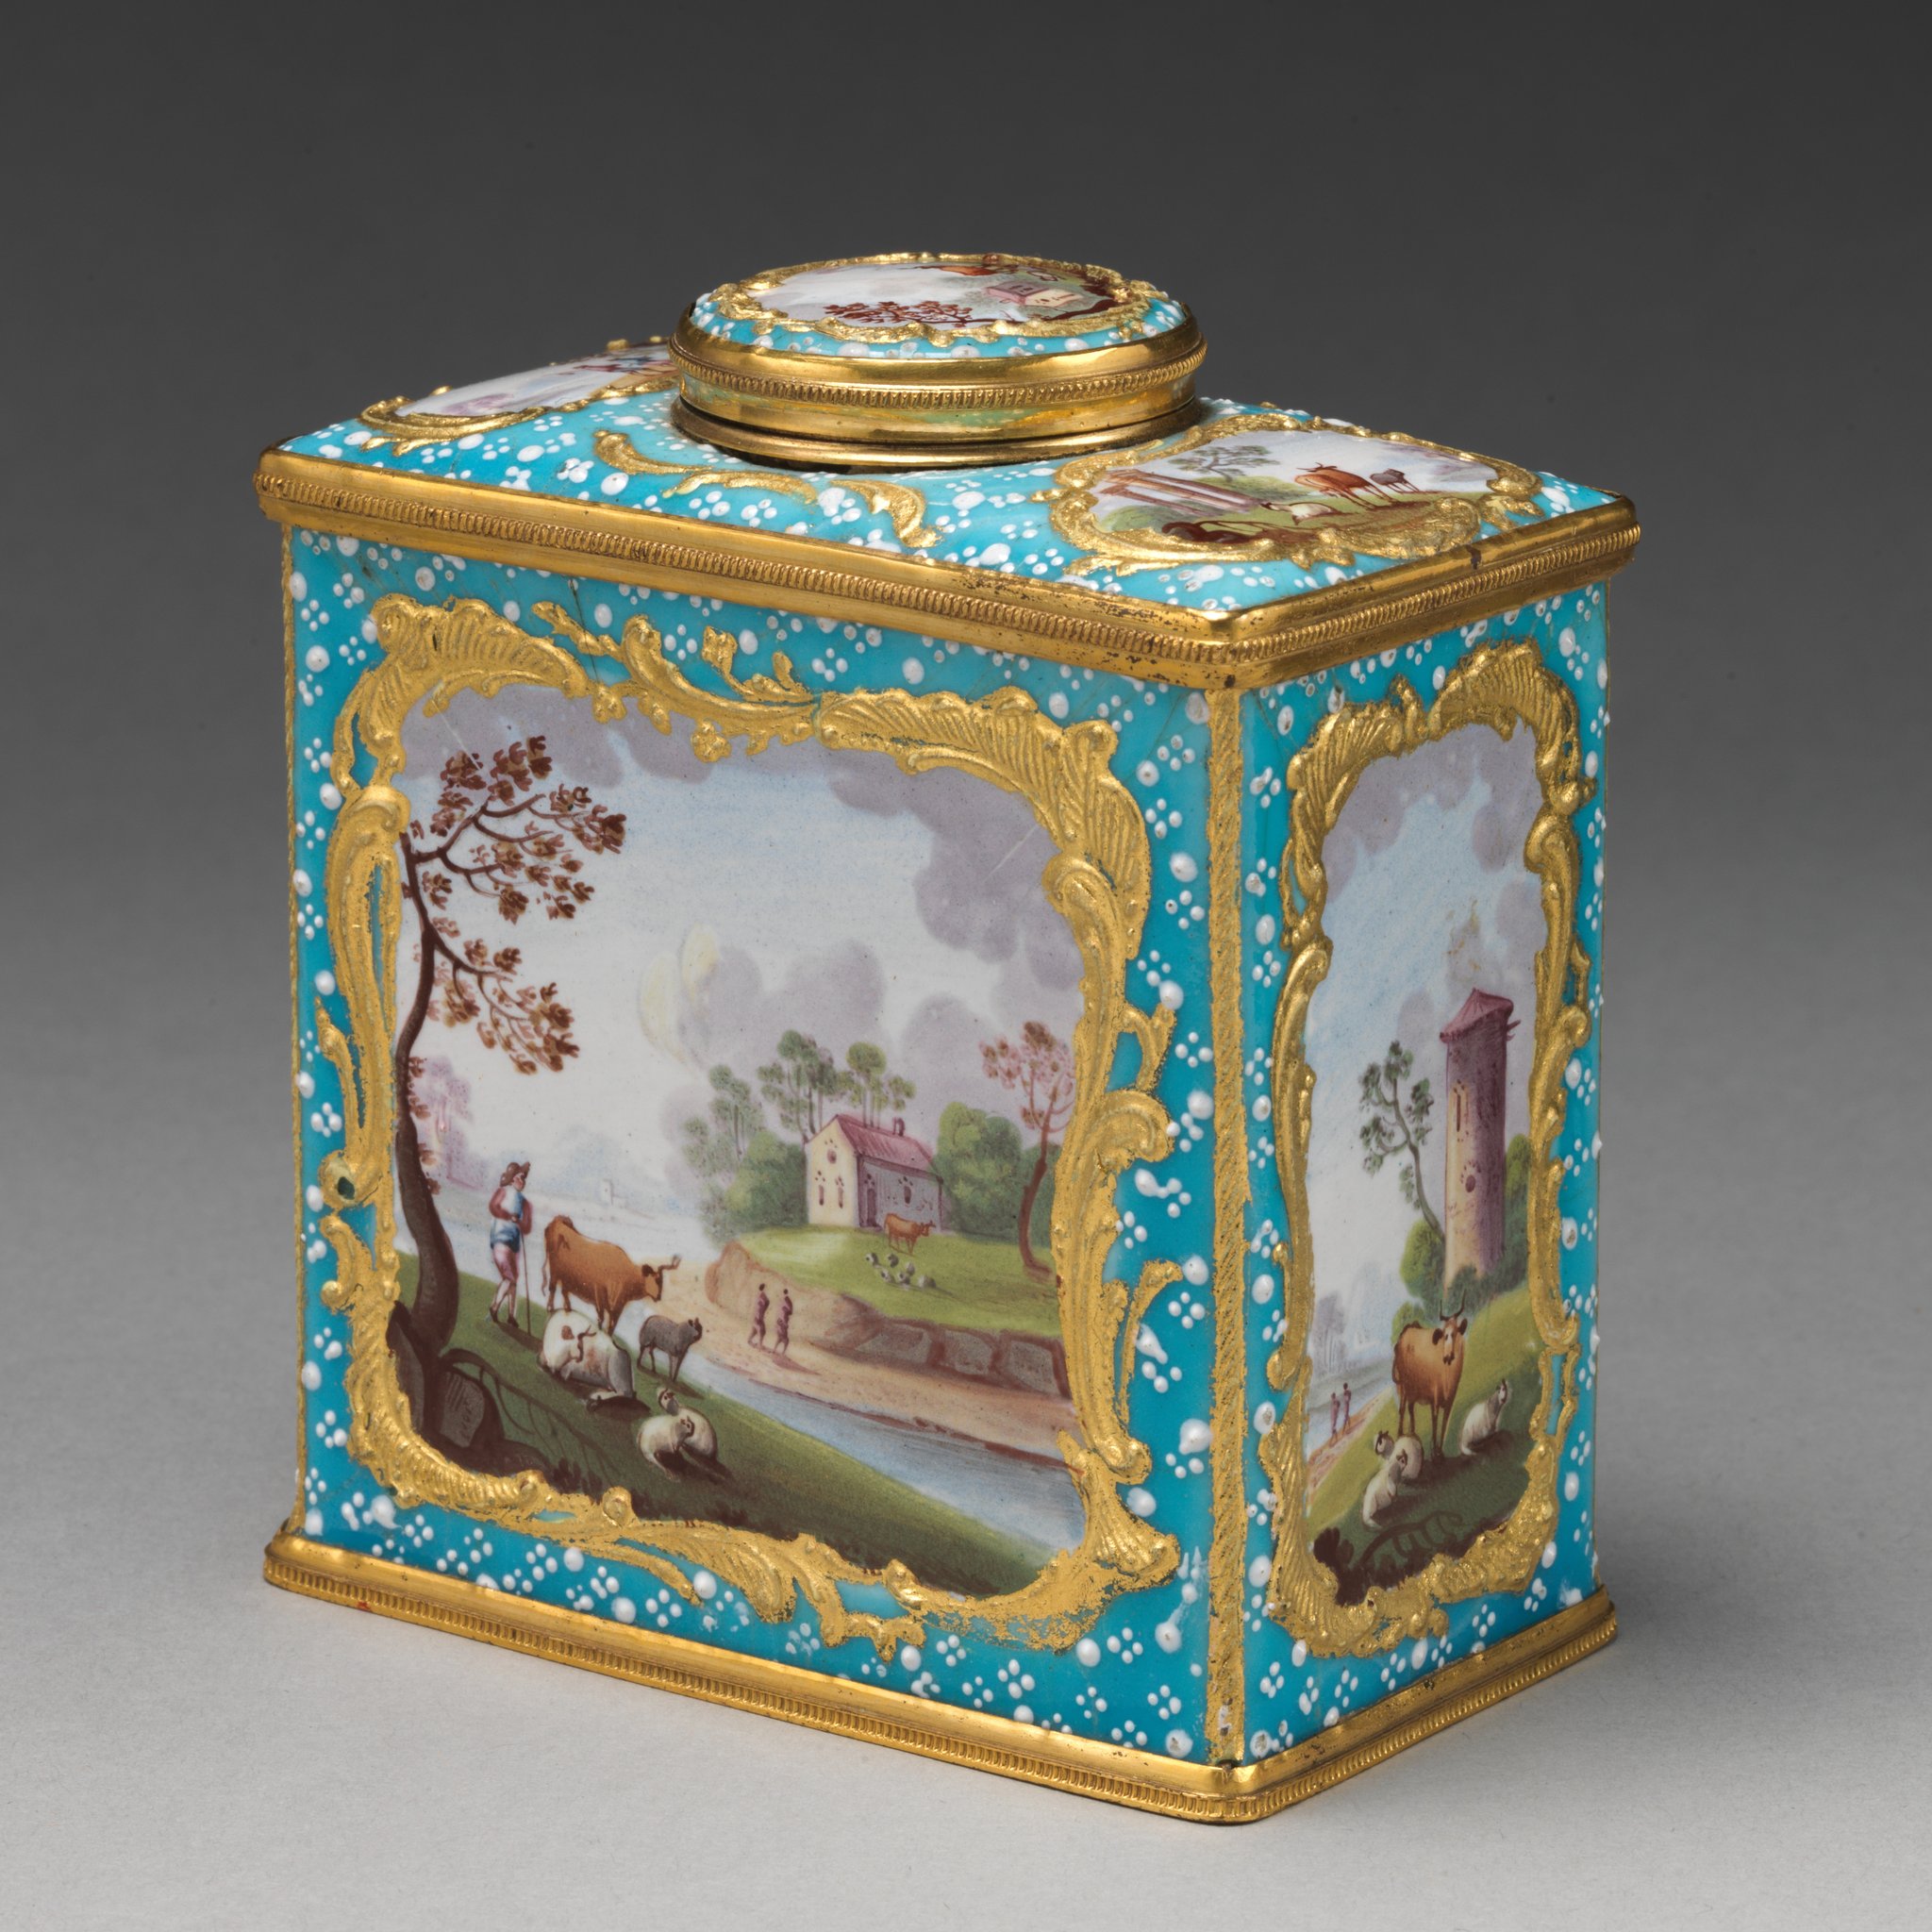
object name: tea caddy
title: Tea caddy (one of a pair)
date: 1765-1770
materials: copper, enamel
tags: cows,donkeys,sheep